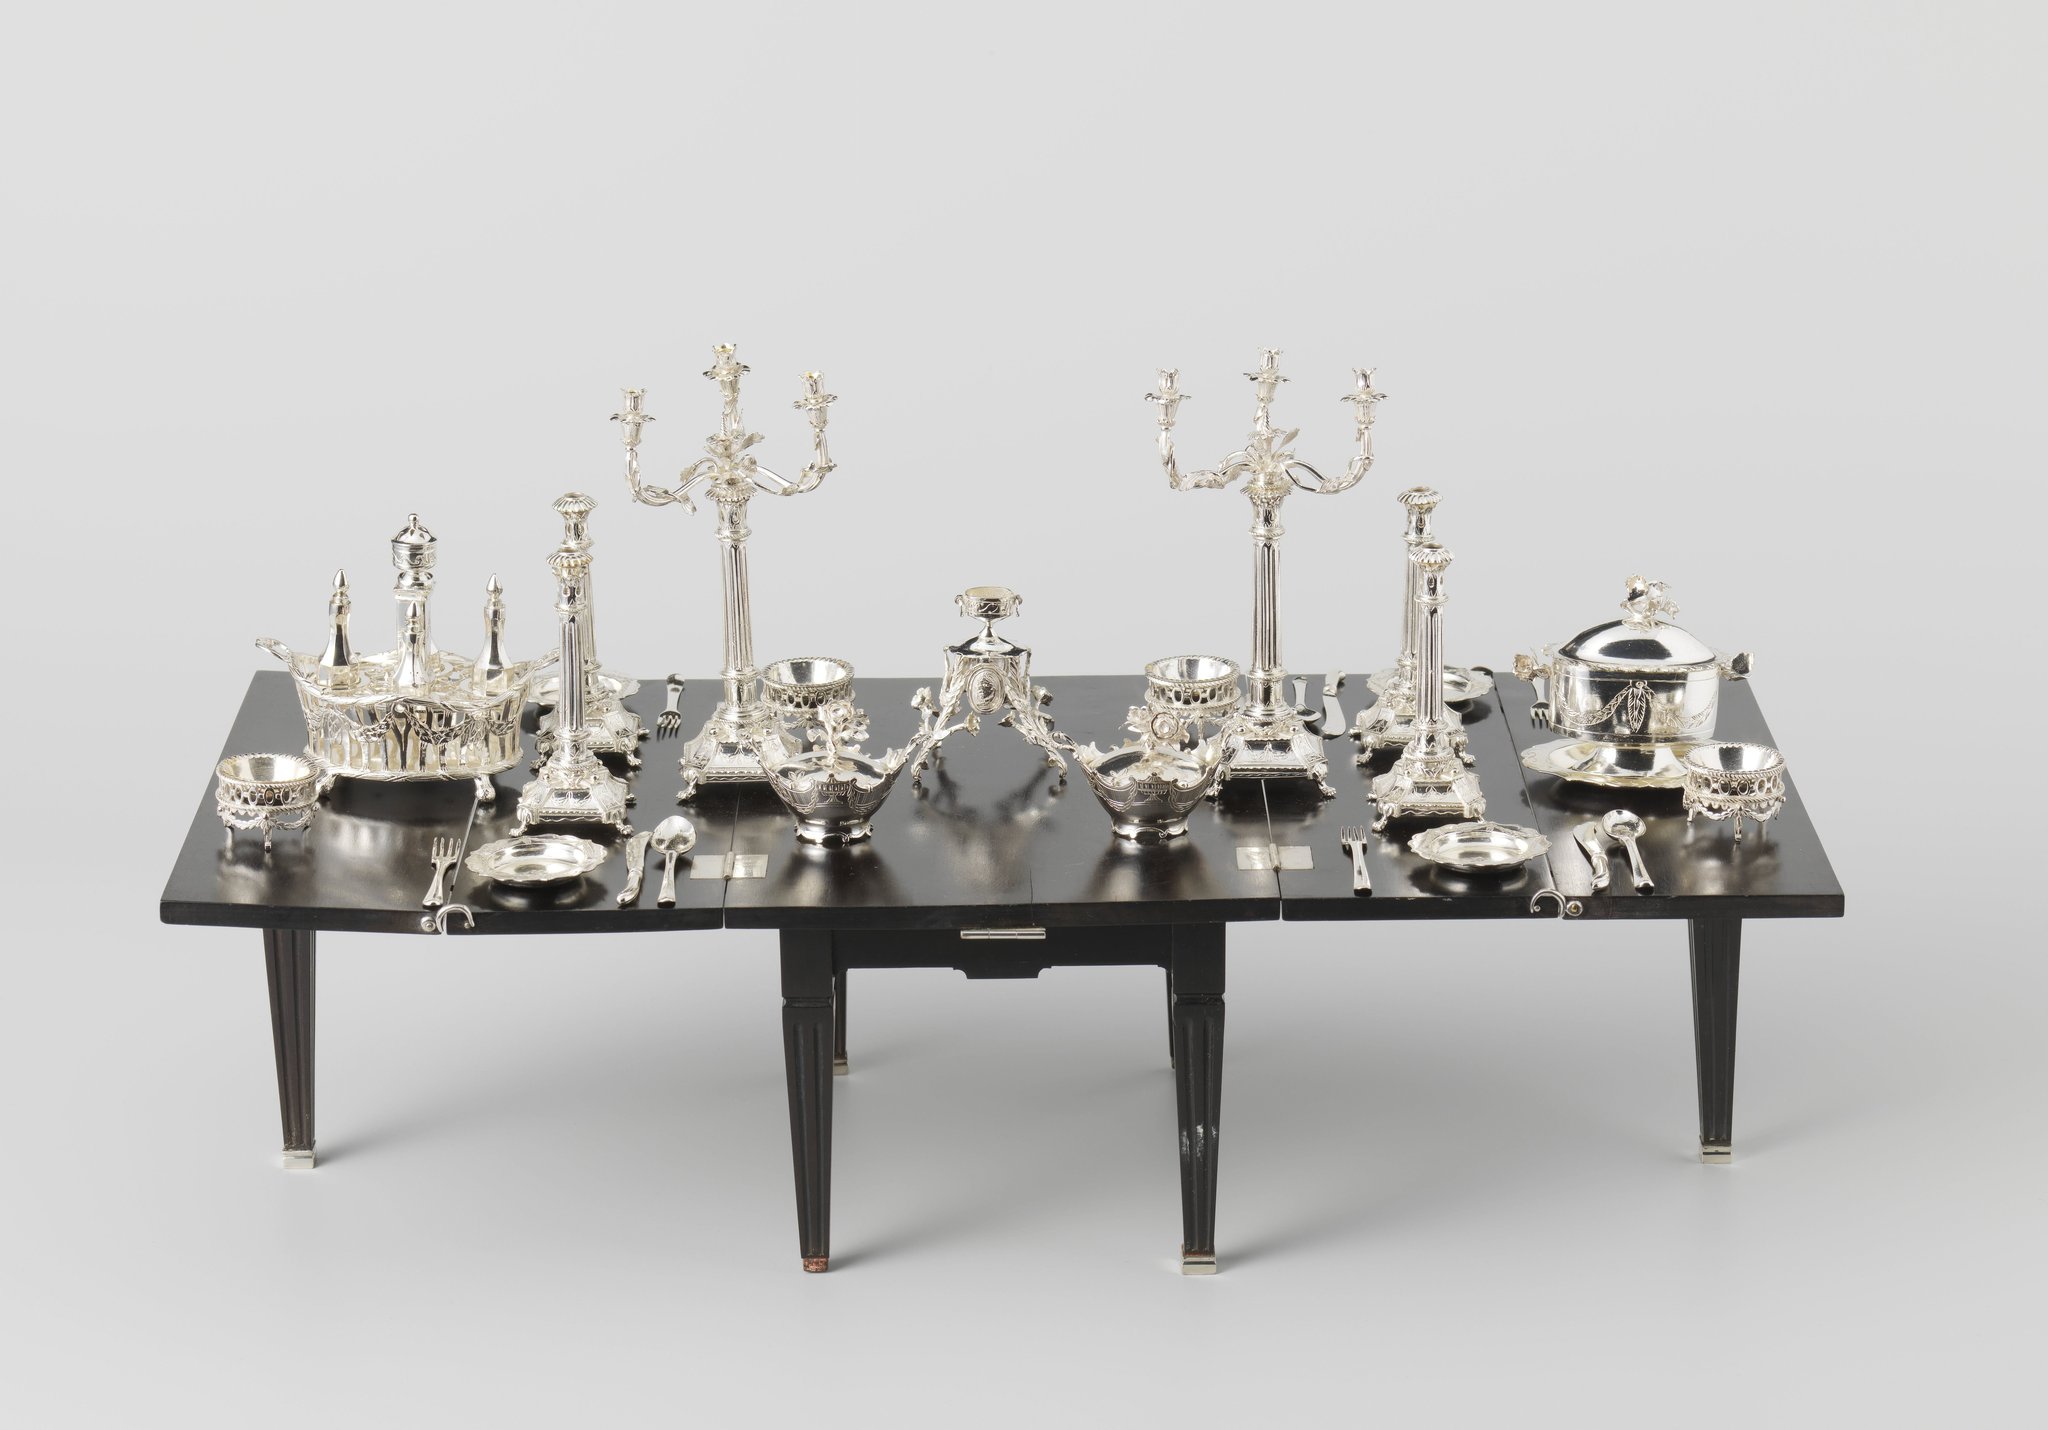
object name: miniature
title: Vork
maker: Anonymous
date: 1700-1800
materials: silver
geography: netherlands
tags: fork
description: Vork met vier tanden en een licht gebogen steel. De steel heeft een middenrichel en dubbel lof. De vork is gelijk aan drie vorken met invnrs. BK-NM-11177-225, BK-NM-11177-227 en BK-NM-11177-228. De vork is niet gemerkt.